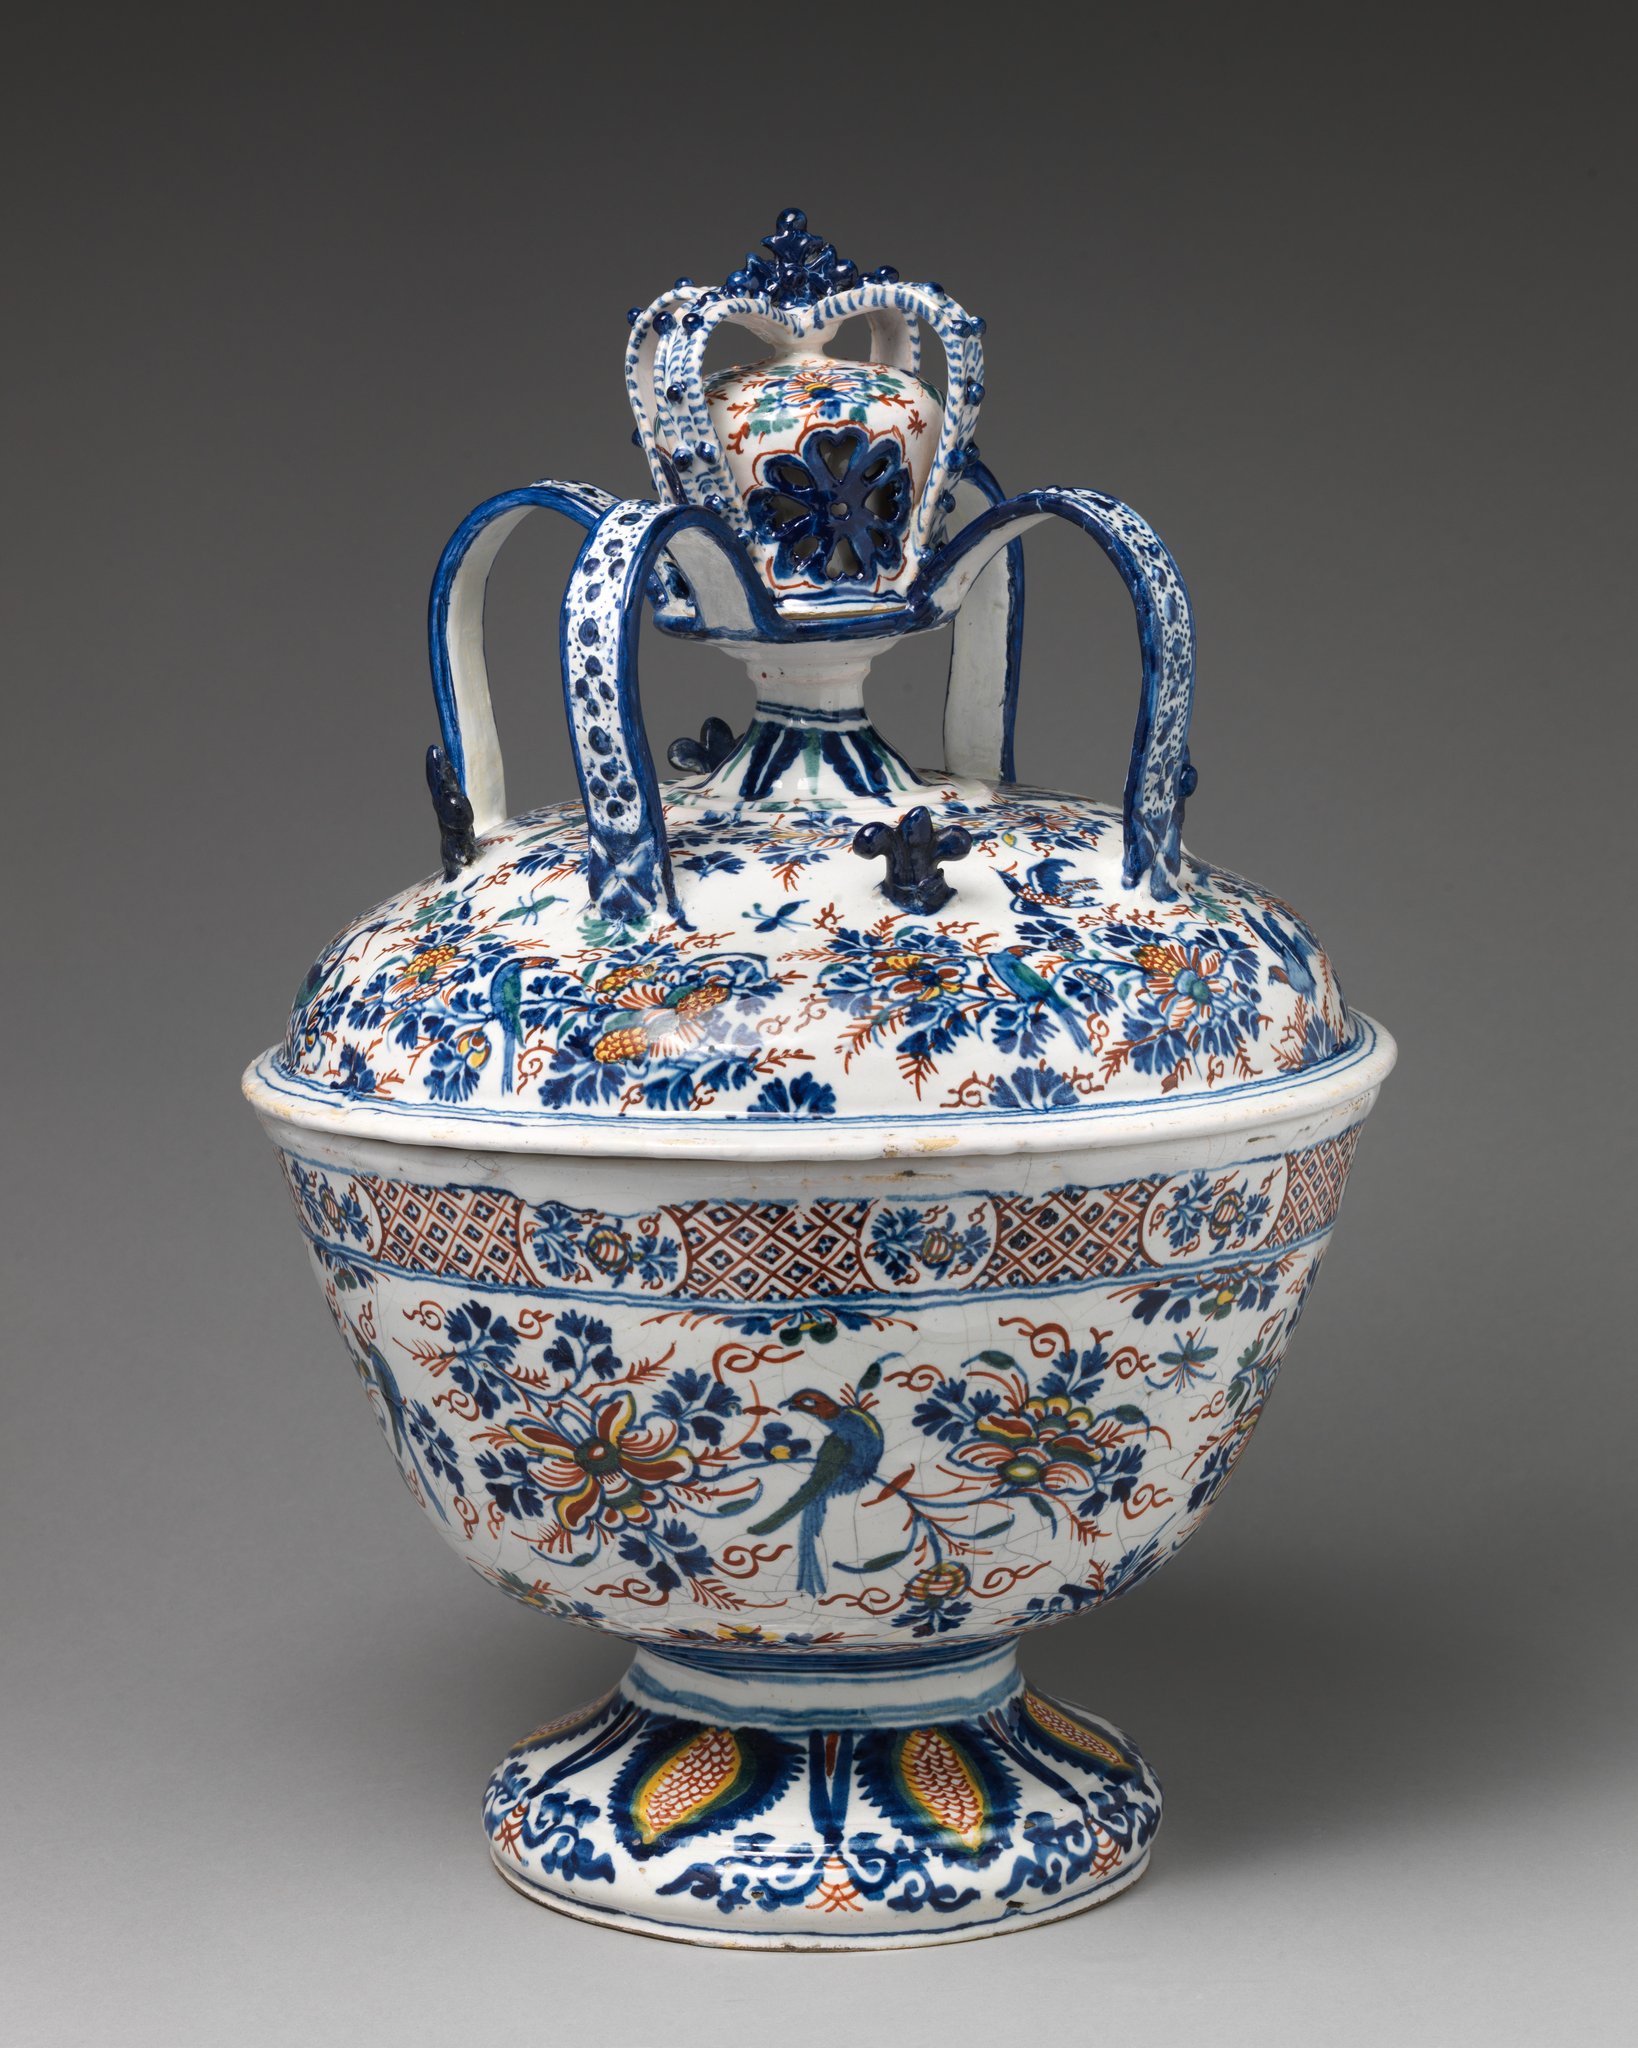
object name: punch bowl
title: Ceremonial punch bowl with cover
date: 1705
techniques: glazing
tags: birds,flowers